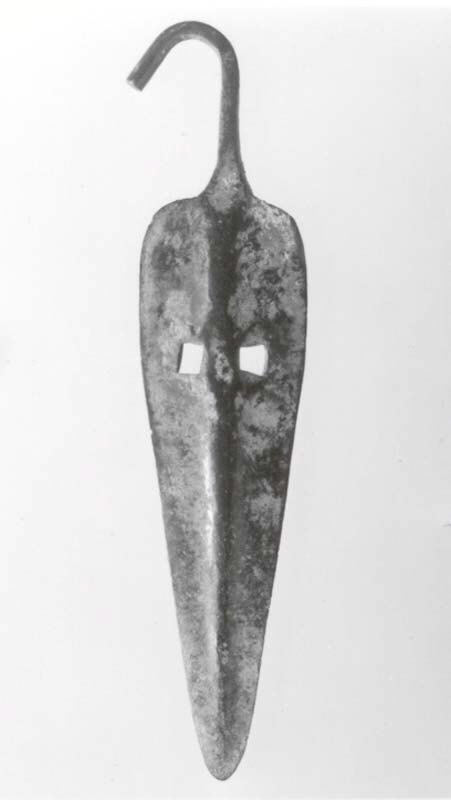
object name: spearhead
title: Spearhead with bent tang and slotted blade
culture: hattian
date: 2300-2000 BCE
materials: copper alloy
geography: central anatolia